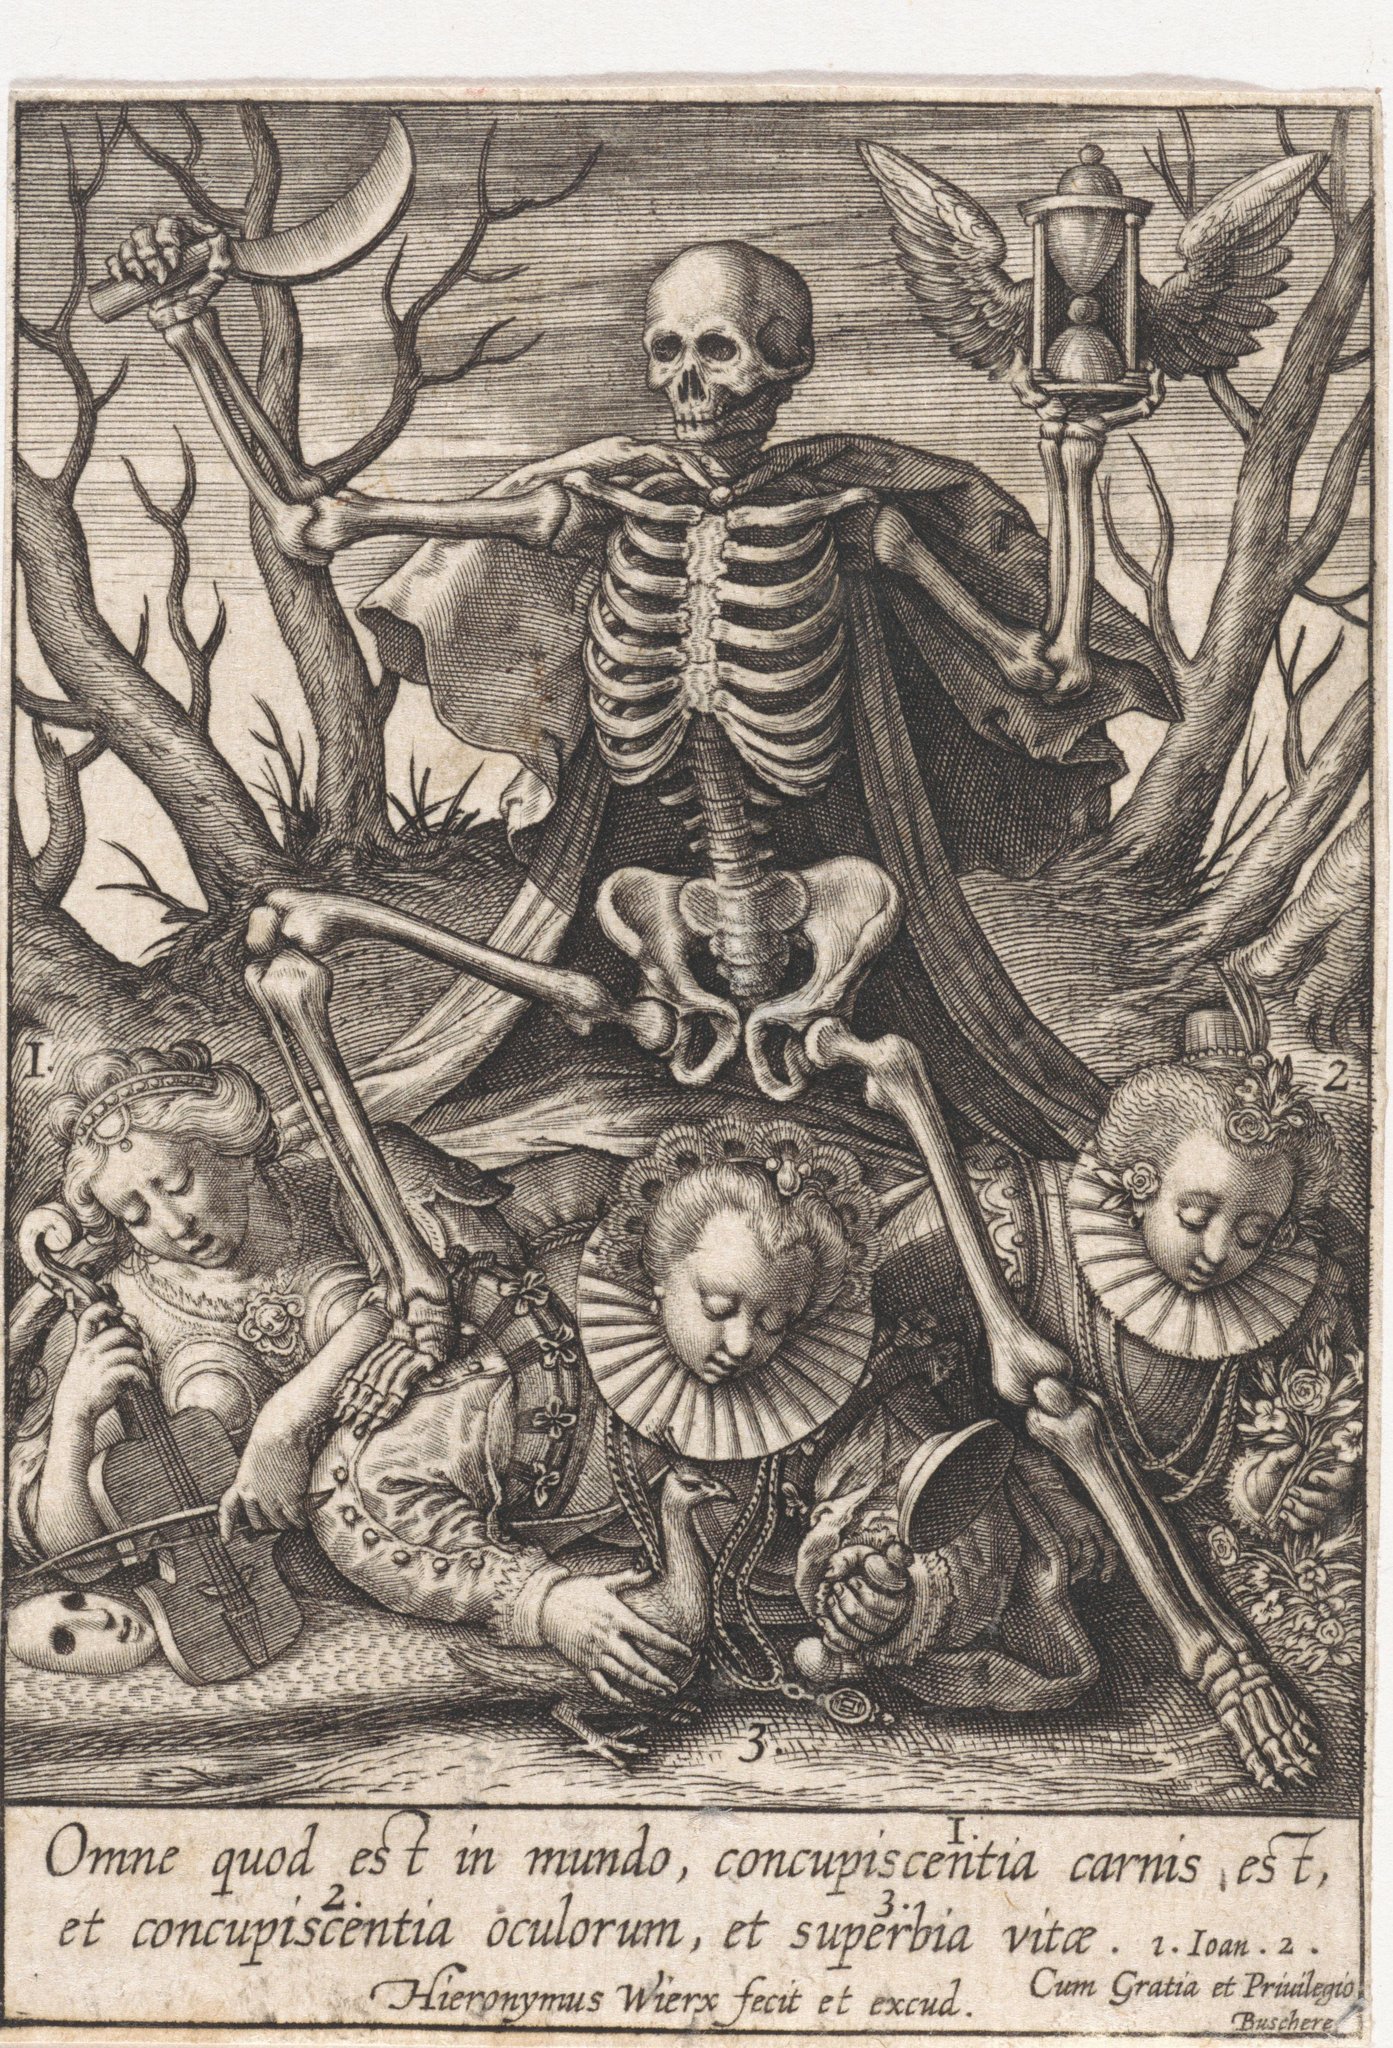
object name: print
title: Allegorie op de vergankelijkheid (Vanitas)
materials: paper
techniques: engraving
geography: antwerp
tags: scenes symbolizing 'vanitas', death as skeleton, pride; 'superbia' (ripa) ~ personification of one of the seven deadly sins, wealth, opulence; 'opulenza', 'richezza' (ripa), desire; 'desiderio' (ripa)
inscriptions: collector's mark: Lugt 2760, collector's mark: Lugt 2228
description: De Dood vertrapt drie rijk geklede dames die respectievelijk verlangen, rijkdom en trots personifiëren. In de marge een tweeregelig Bijbelcitaat uit 1 Joh. 2 in het Latijn.